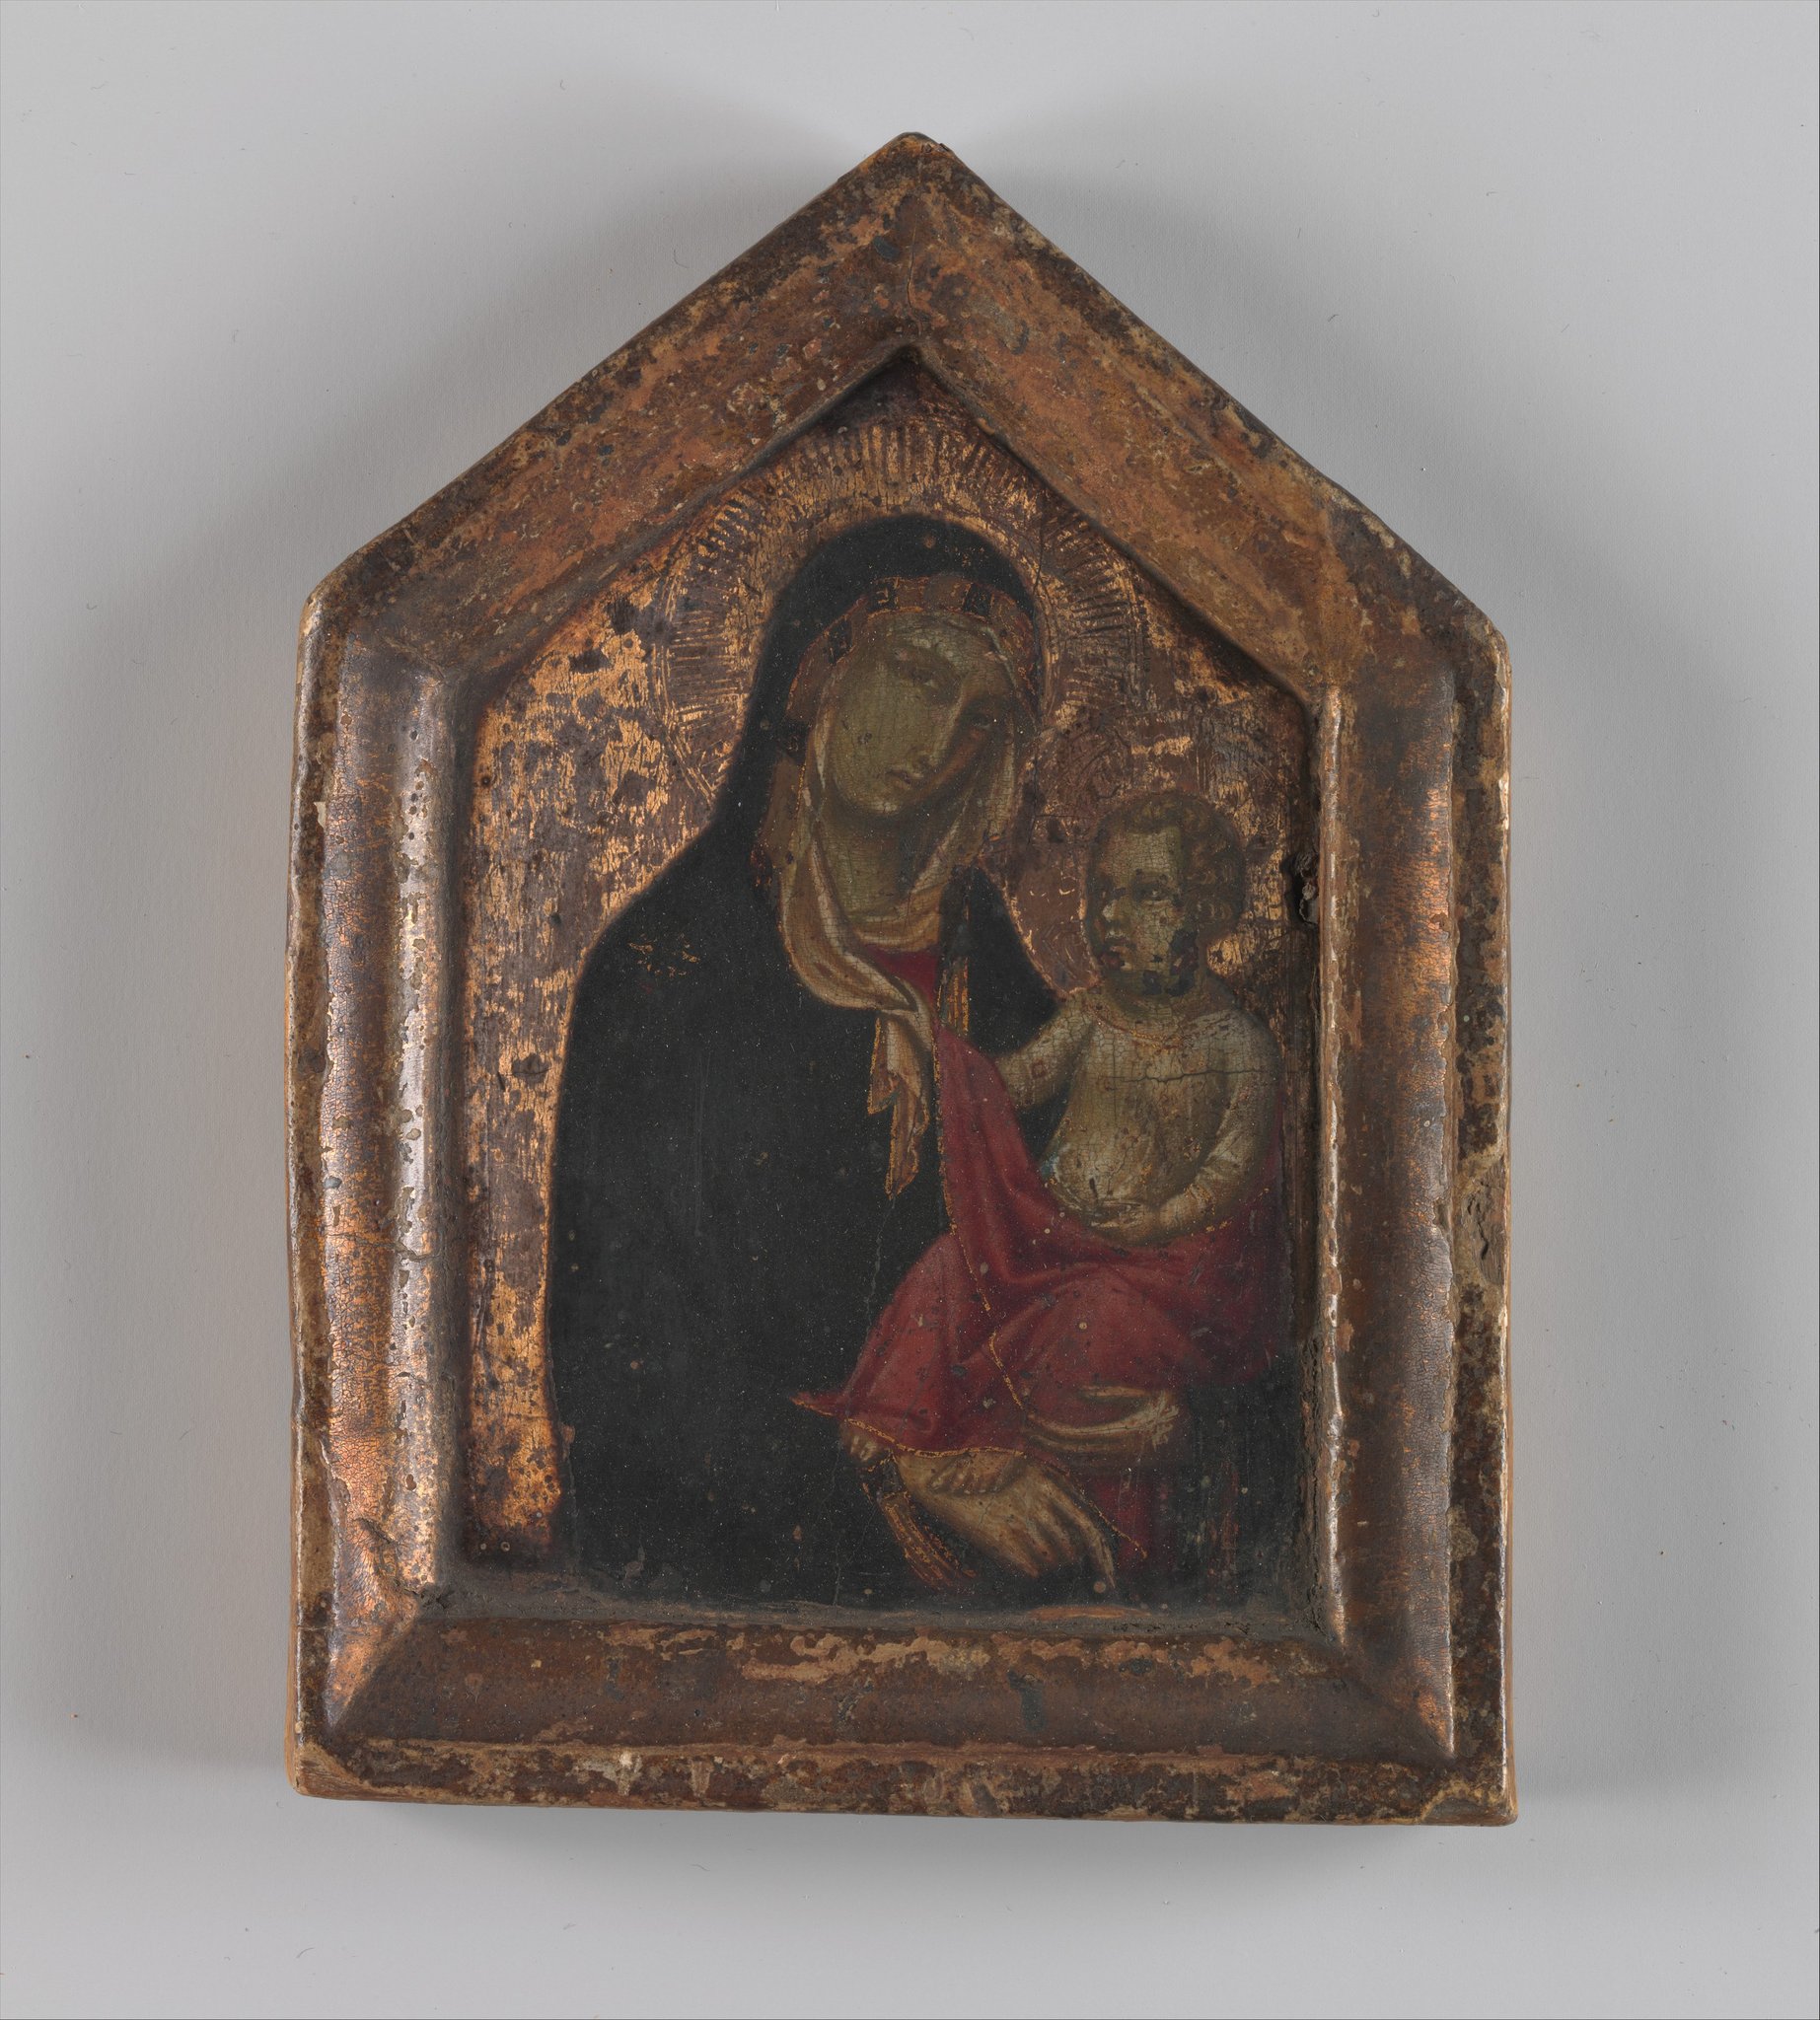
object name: painting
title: Madonna and Child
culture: italian, tuscany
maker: italian [tuscan] painter, first quarter of 14th century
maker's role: artist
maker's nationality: italian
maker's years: 1300-1324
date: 1301-1325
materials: panel, paint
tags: madonna and child